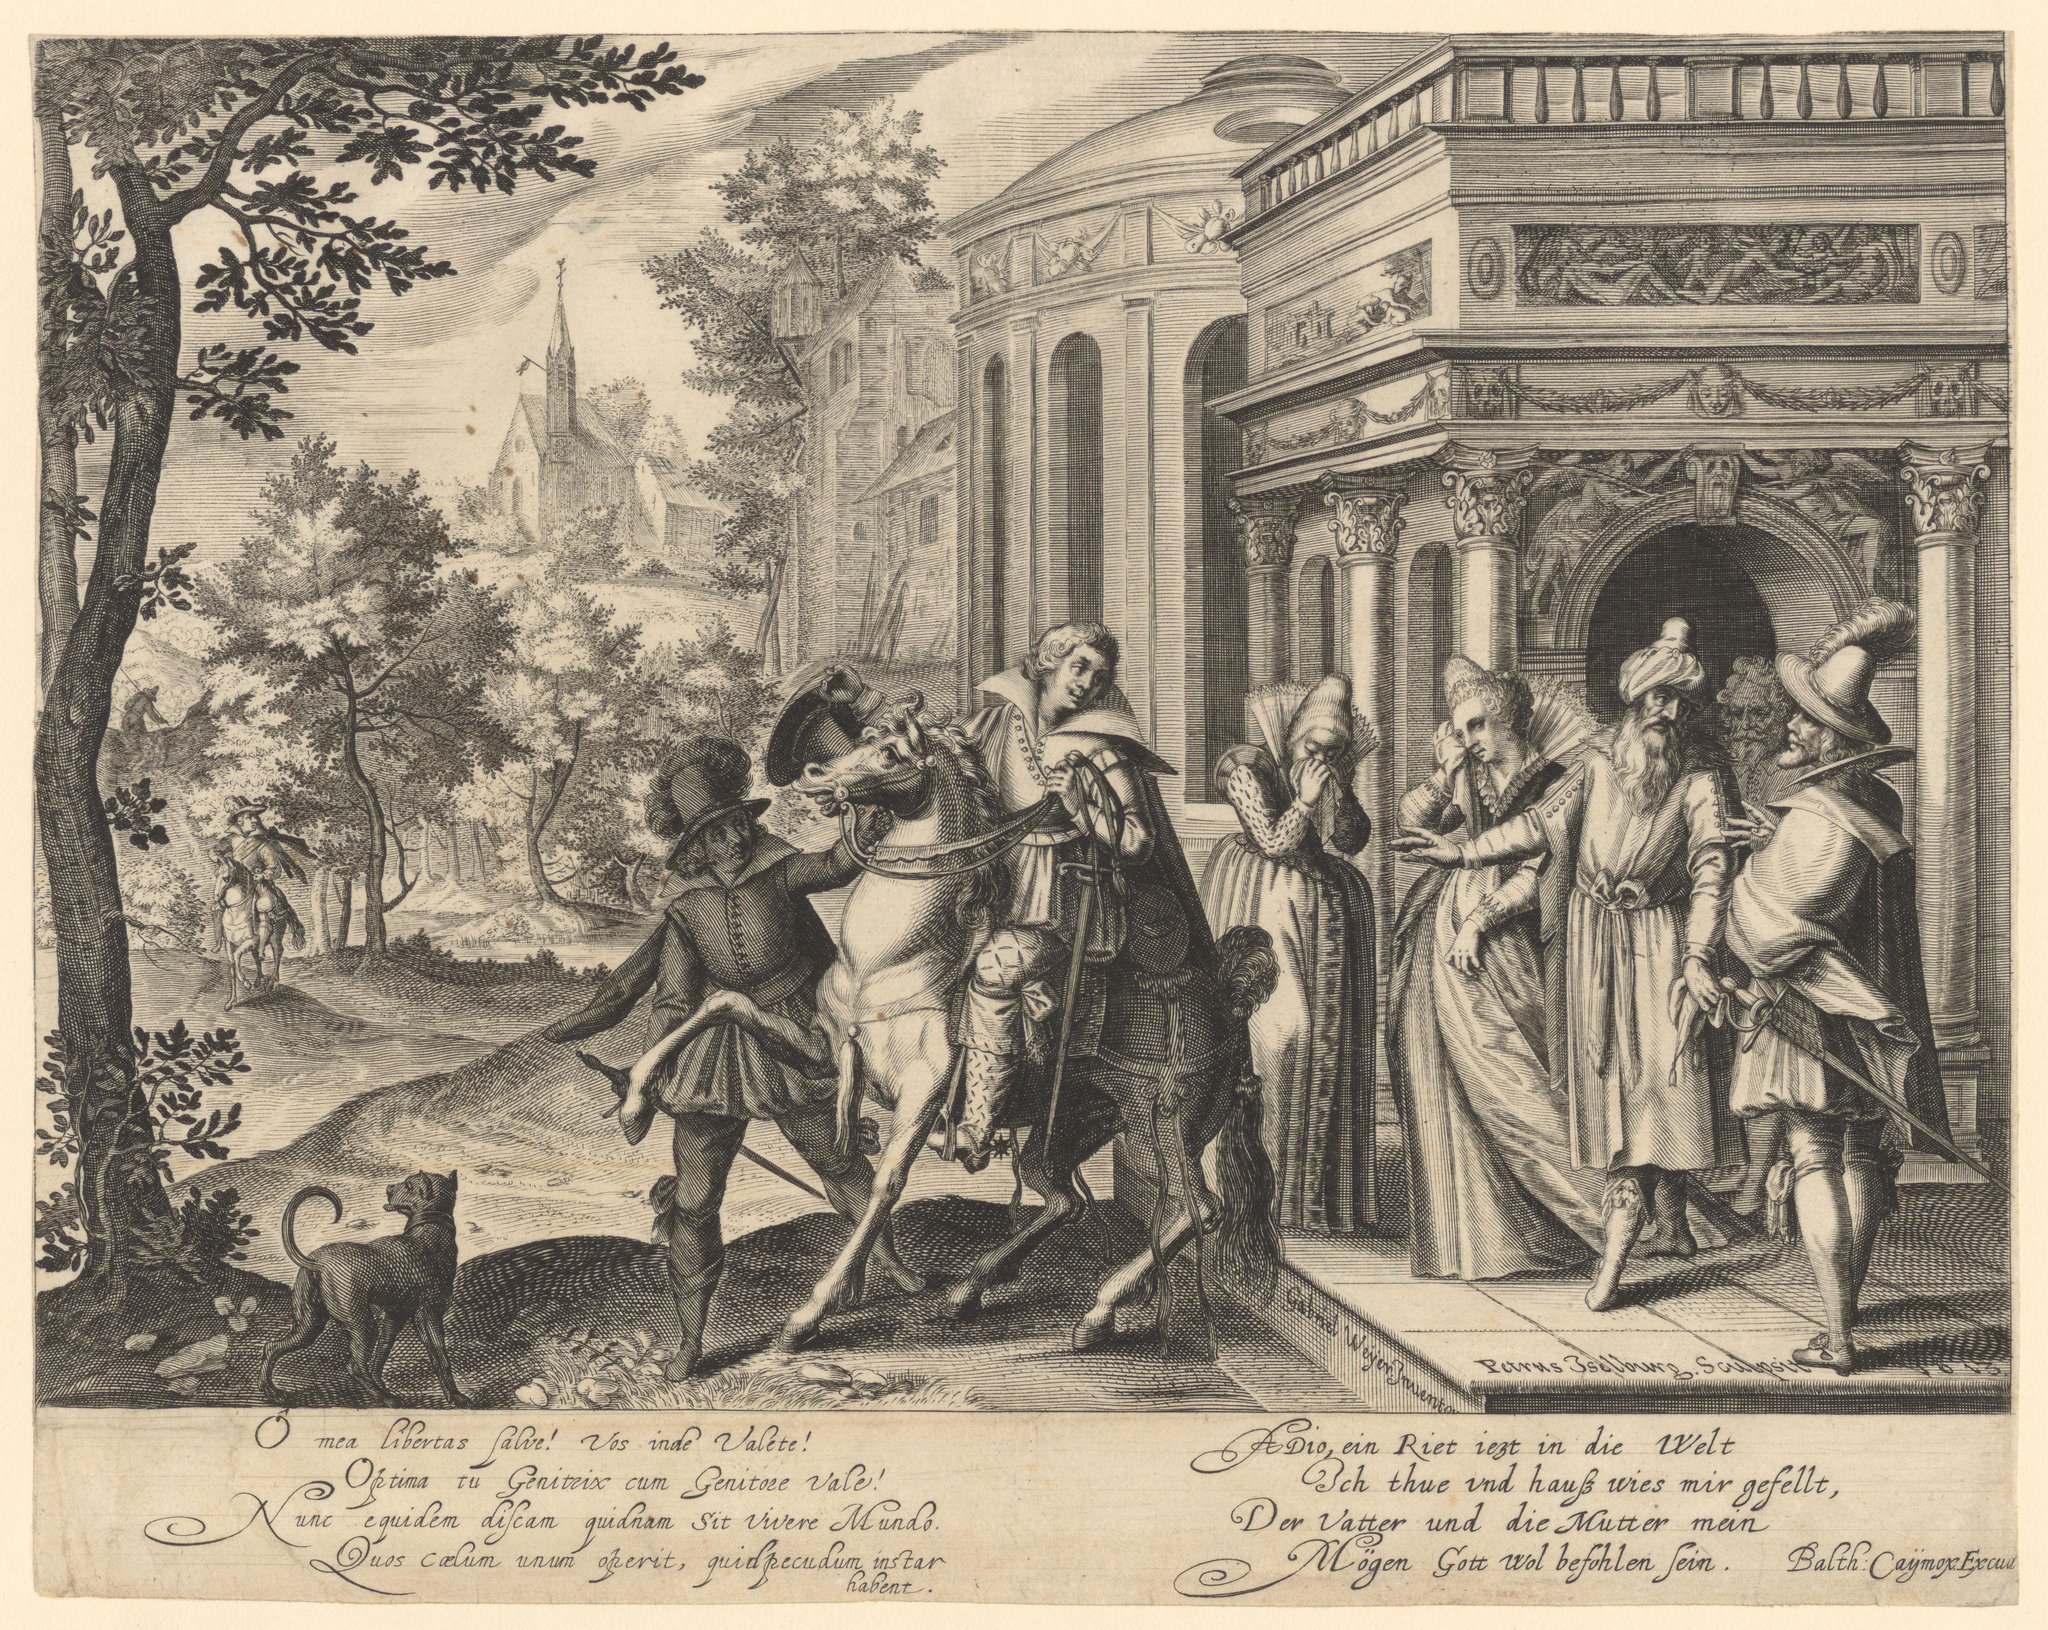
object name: print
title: Vertrek van de verloren zoon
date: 1613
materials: paper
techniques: engraving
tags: leave-taking and departure of the prodigal son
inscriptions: collector's mark: Lugt 1041c, collector's mark: Lugt 2228